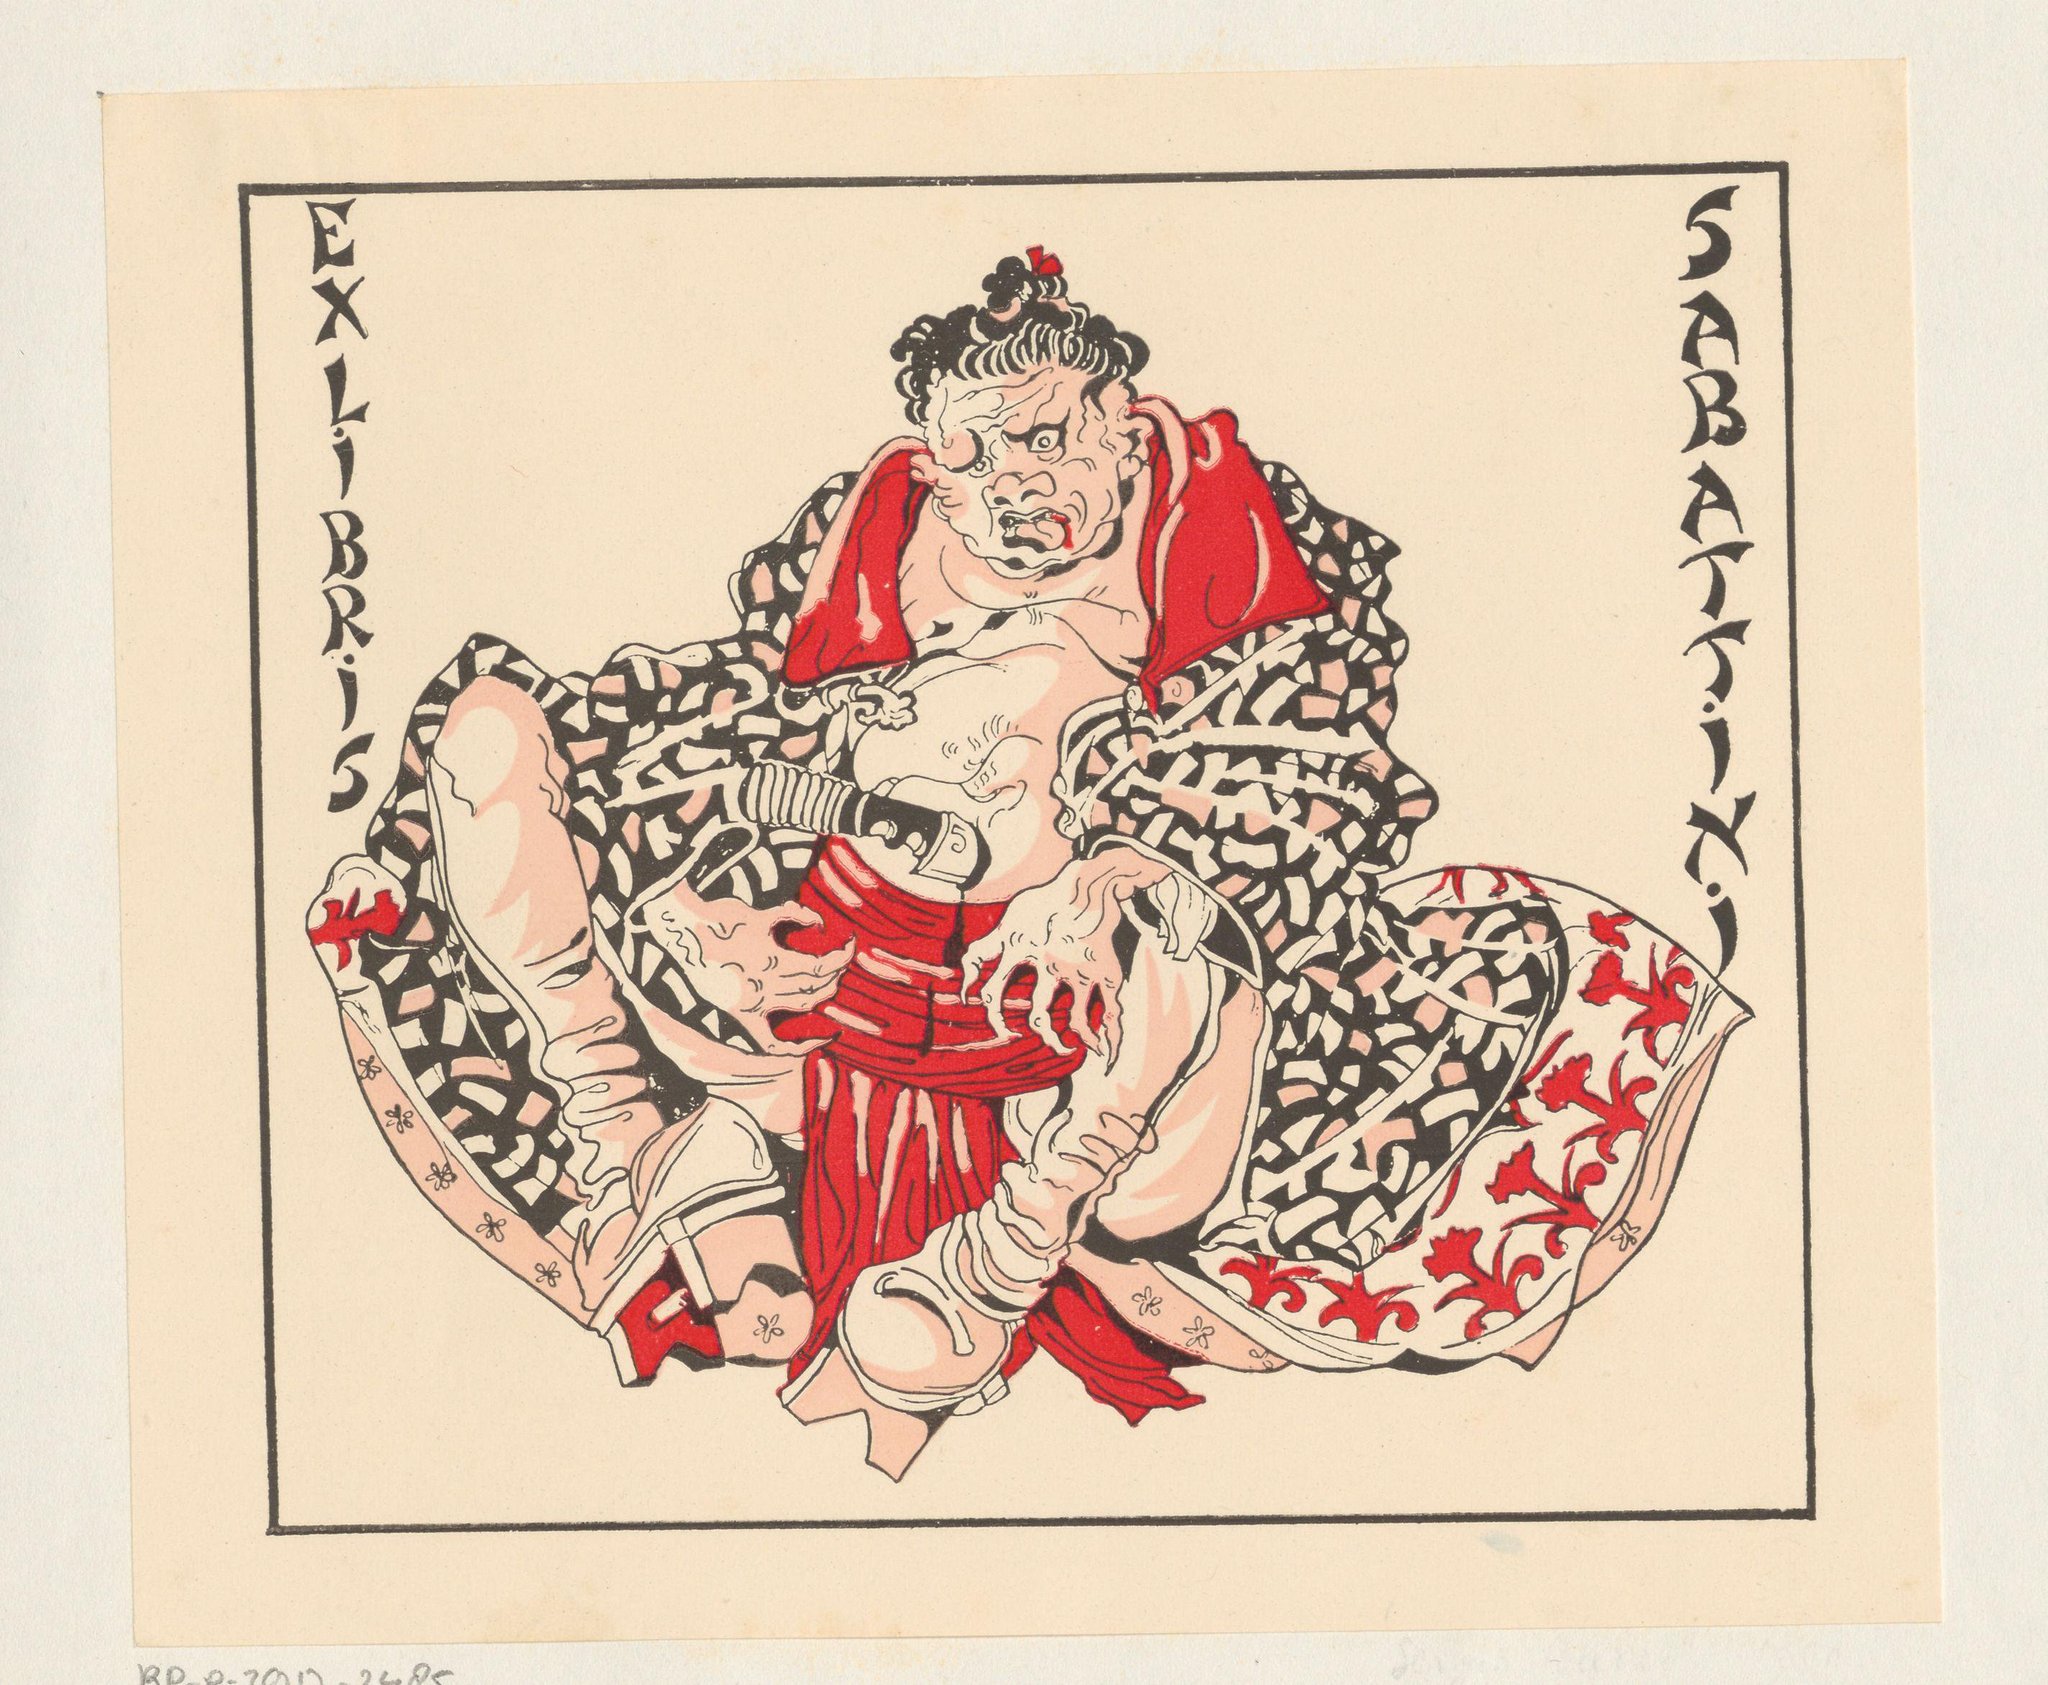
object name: bookplate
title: Ex libris van Gino Sabattini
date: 1943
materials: paper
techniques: autotype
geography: italy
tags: gino sabattini, hacking and thrusting weapons: dagger, japanese, mantle, gown, dress (symbol of sovereignty), ugly old man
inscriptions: inscription: ‘S. Burzi 1950’